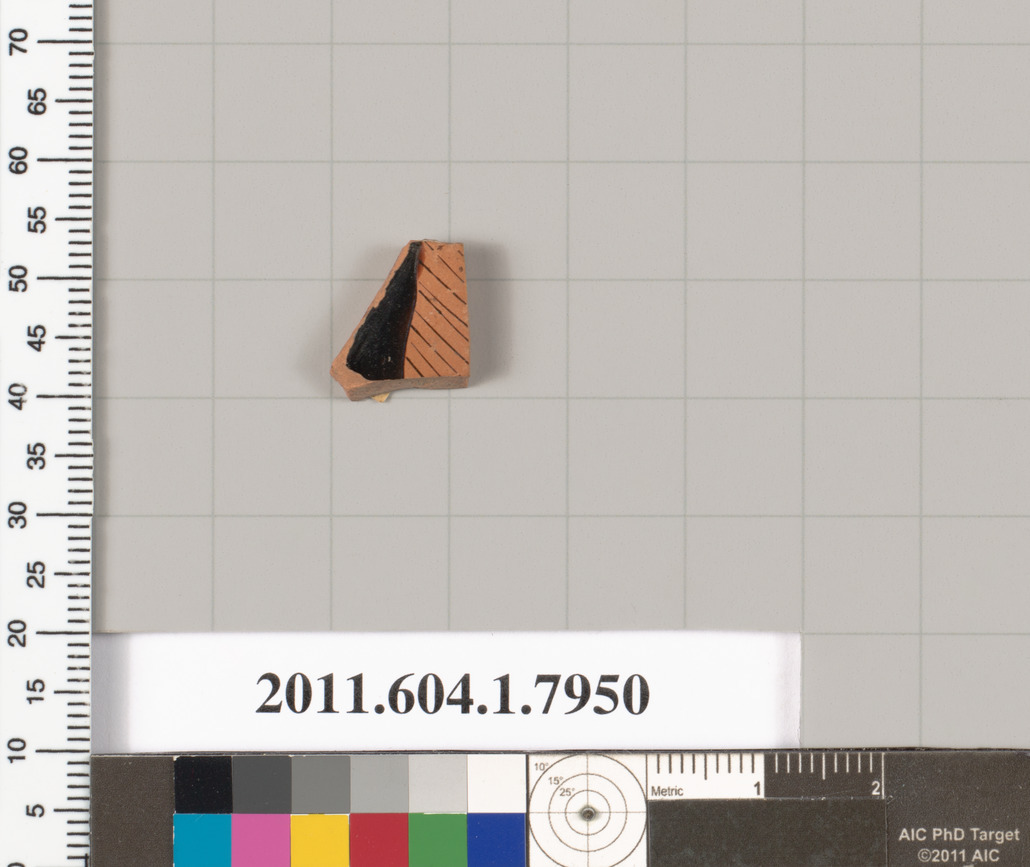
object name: kylix fragment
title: Terracotta fragment of a kylix (drinking cup)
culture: greek, attic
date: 460-450 BCE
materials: terracotta